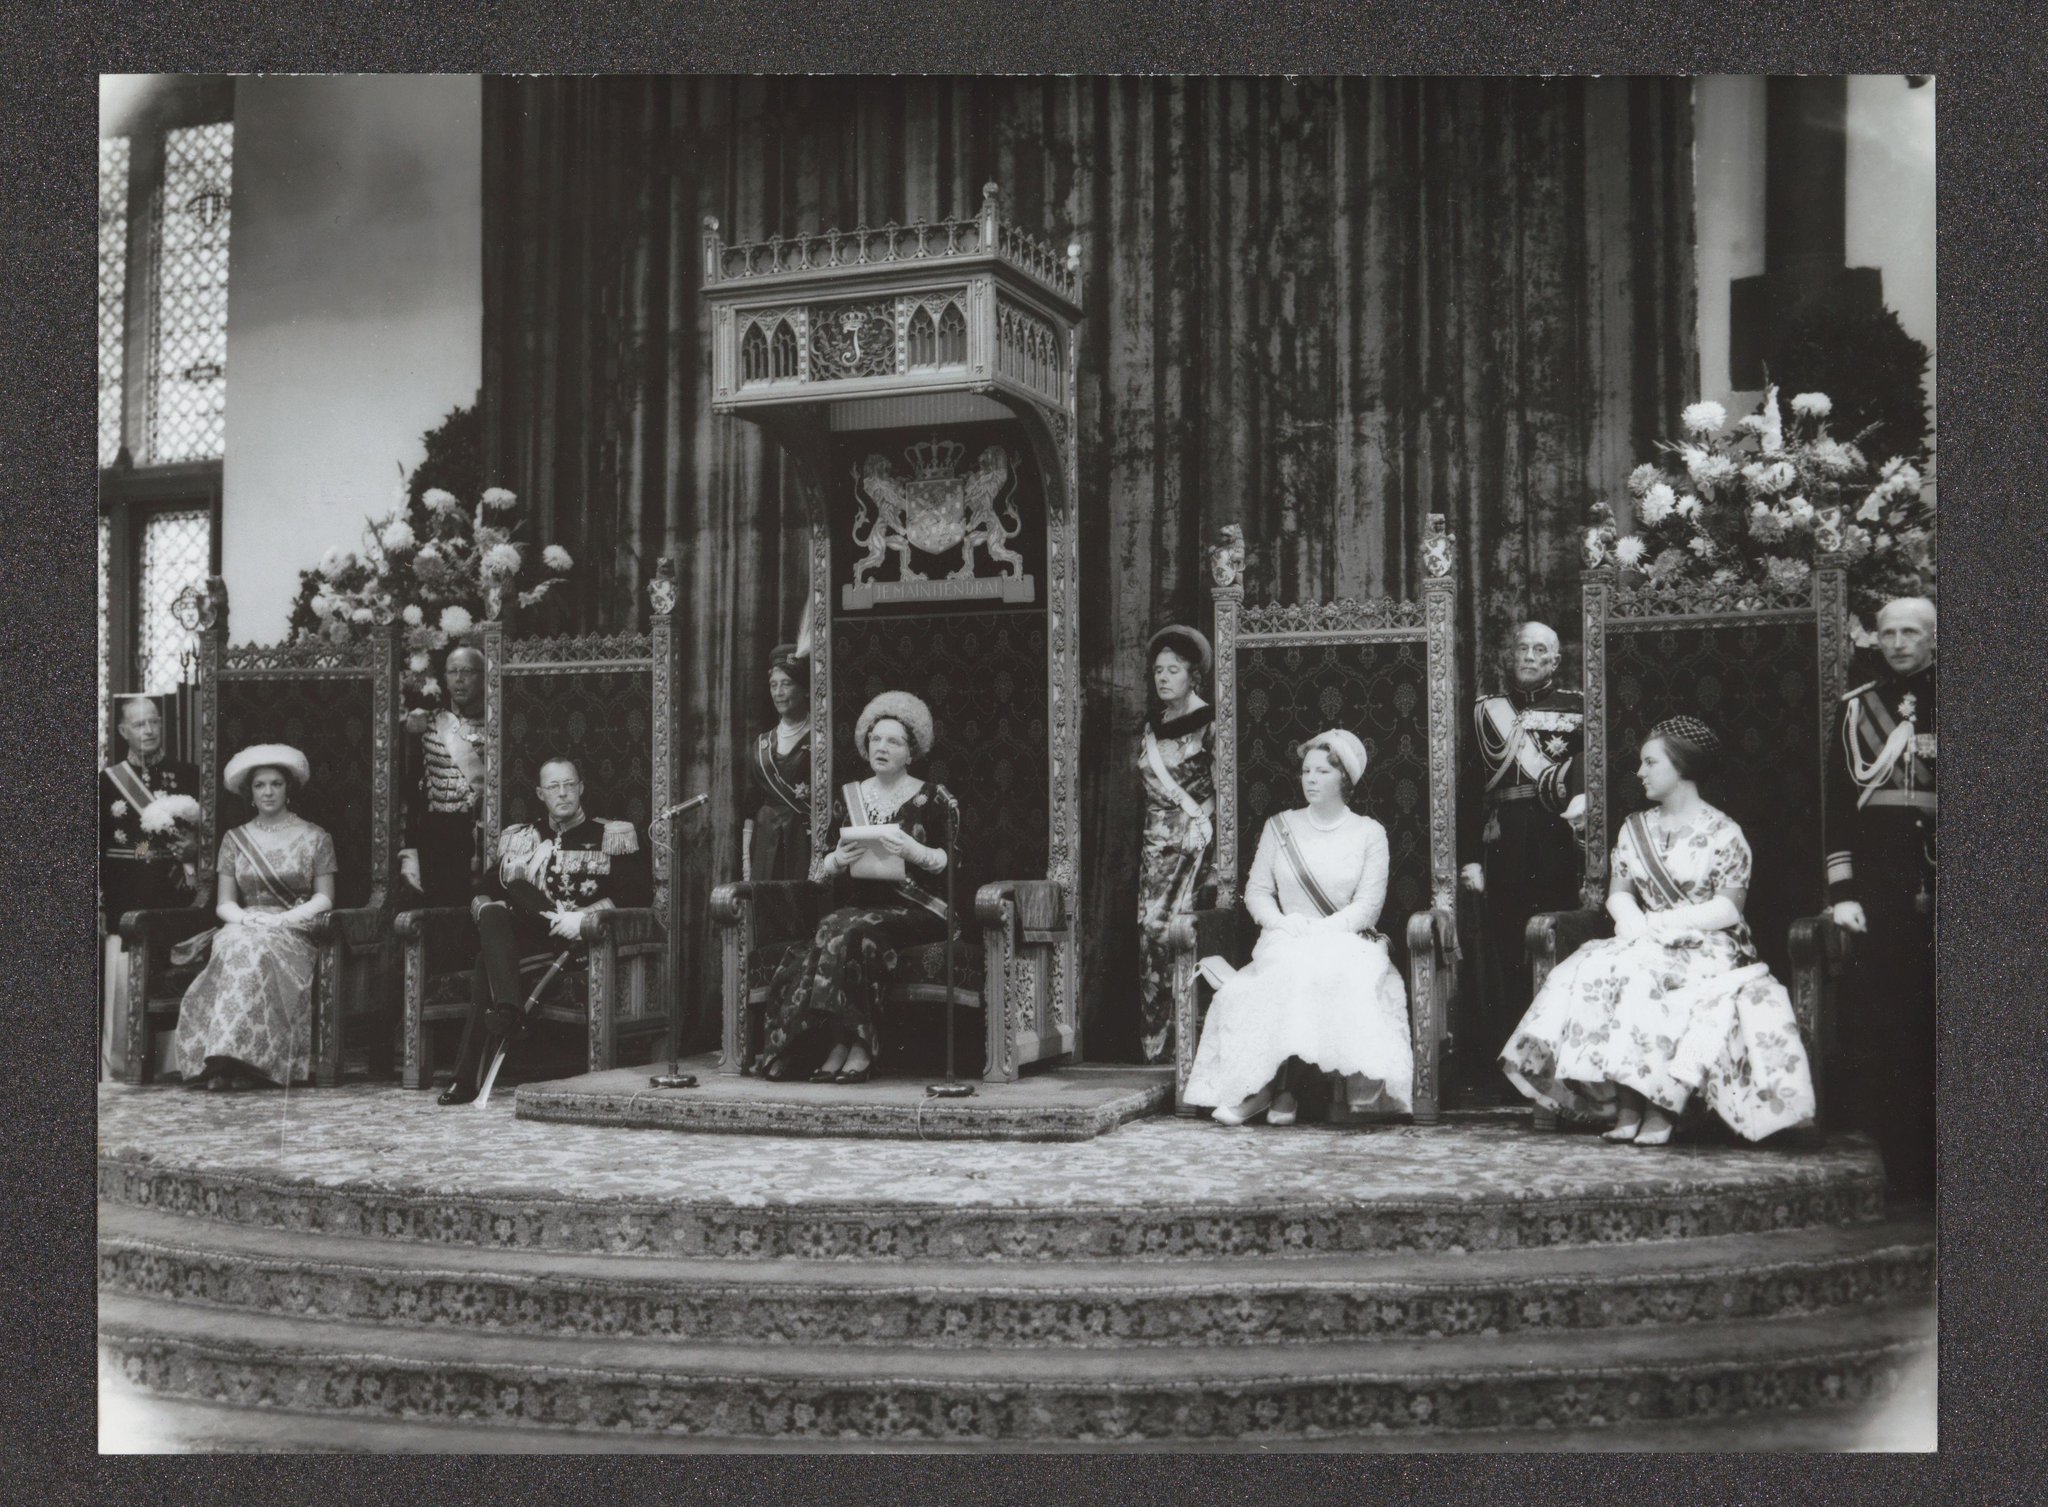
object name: photograph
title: Koningin Juliana opent de Staten Generaal met aan haar zijde prinses Beatrix, prins Bernhard, prinses Irene en prinses Margriet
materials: paper, photographic support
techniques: autotype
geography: netherlands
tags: utrecht, bernhard (prins der nederlanden), the hague, beatrix (koningin der nederlanden), juliana of the netherlands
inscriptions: annotation: ‘At The Hague H.M. Queen Juliana opened the both chambers of the Dutch parliament H.M. Queen Juliana during the openigspeech. At left Princess Irene and Prins Bernhard. At right Princess Beatrix and Princess Margriet. FOTO - ANEFO 19-9-1961’